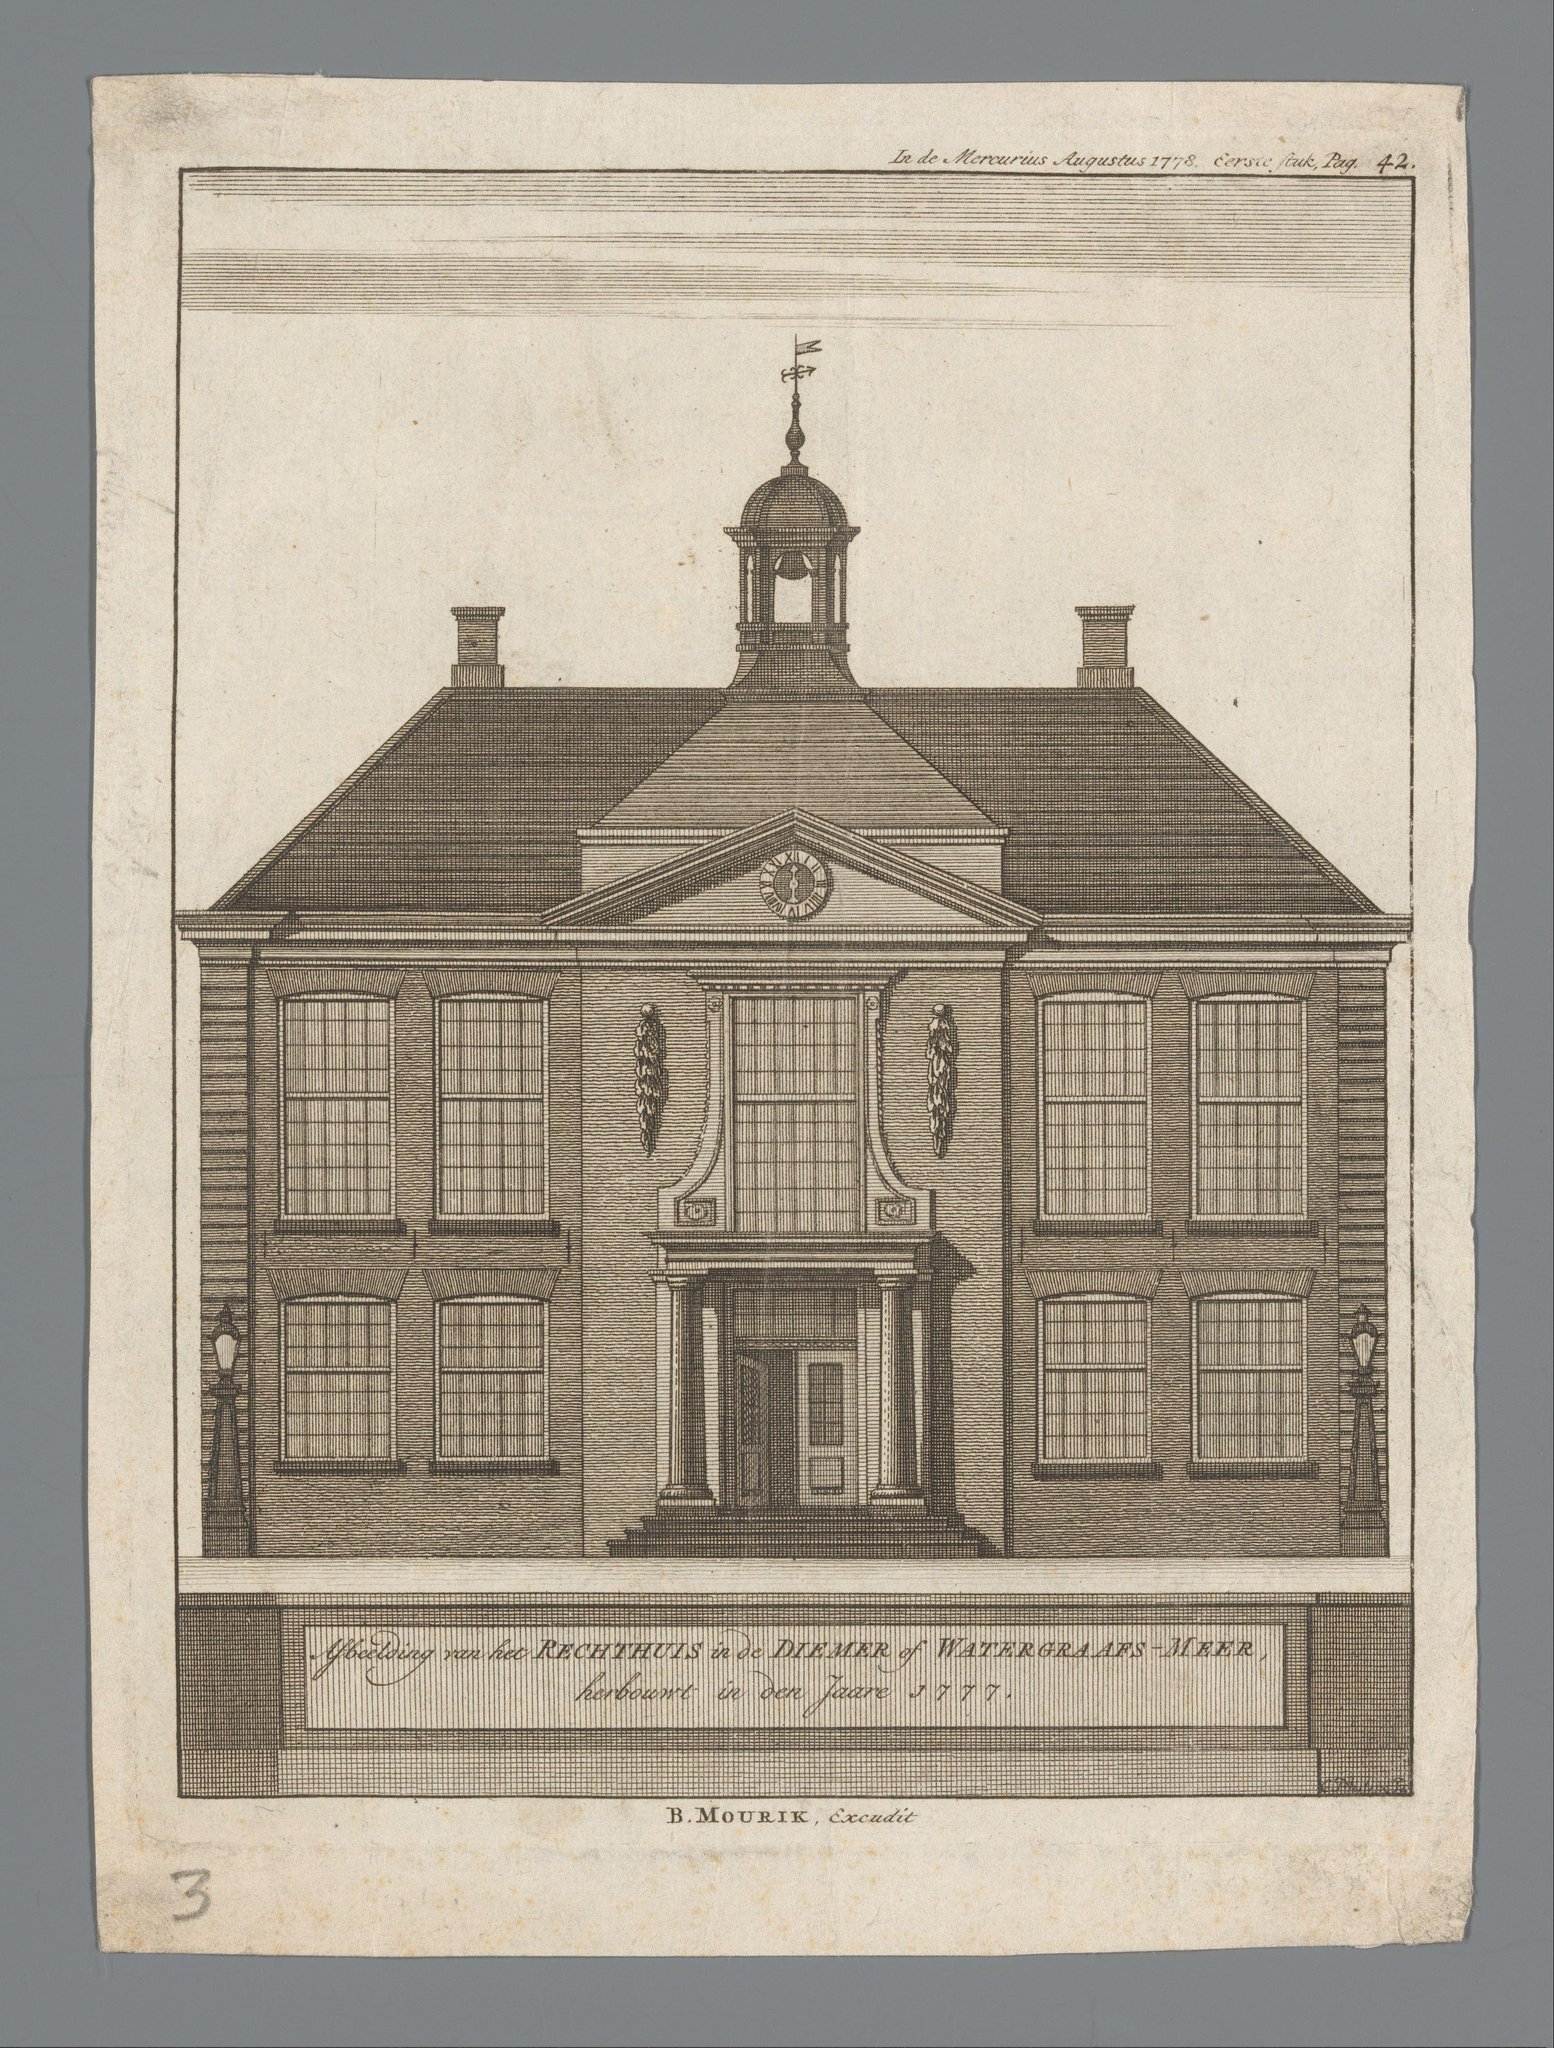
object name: print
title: Vooraanzicht van het Rechthuis in Watergraafsmeer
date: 1778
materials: paper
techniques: engraving, etching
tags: civic architecture; edifices; dwellings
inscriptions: inscription: ‘1808’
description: Prent uit het tijdschrift: De Maandelijkse Nederlandse Mercurius, augustus 1778, eerste stuk.